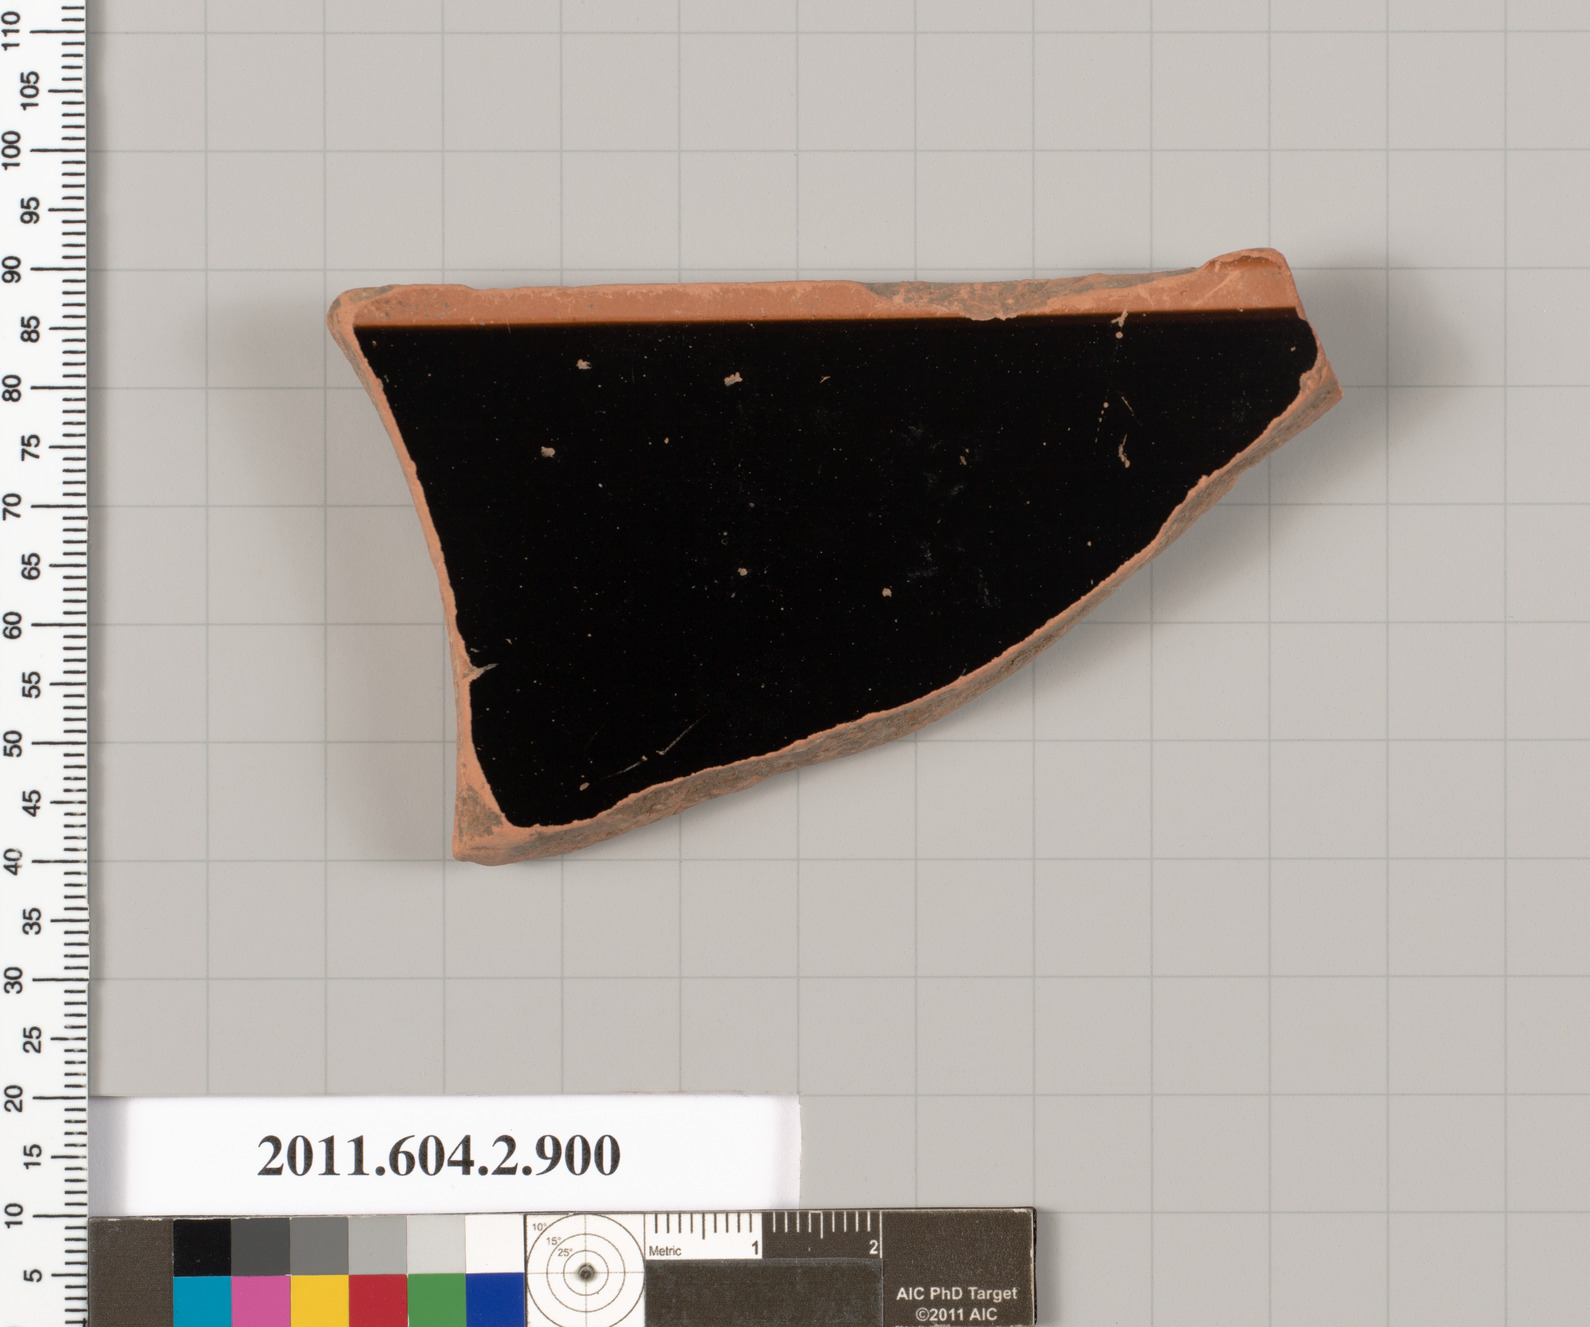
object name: bell krater fragment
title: Terracotta fragment of a bell-krater (bowl for mixing wine and water)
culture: greek, attic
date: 450-440 BCE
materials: terracotta